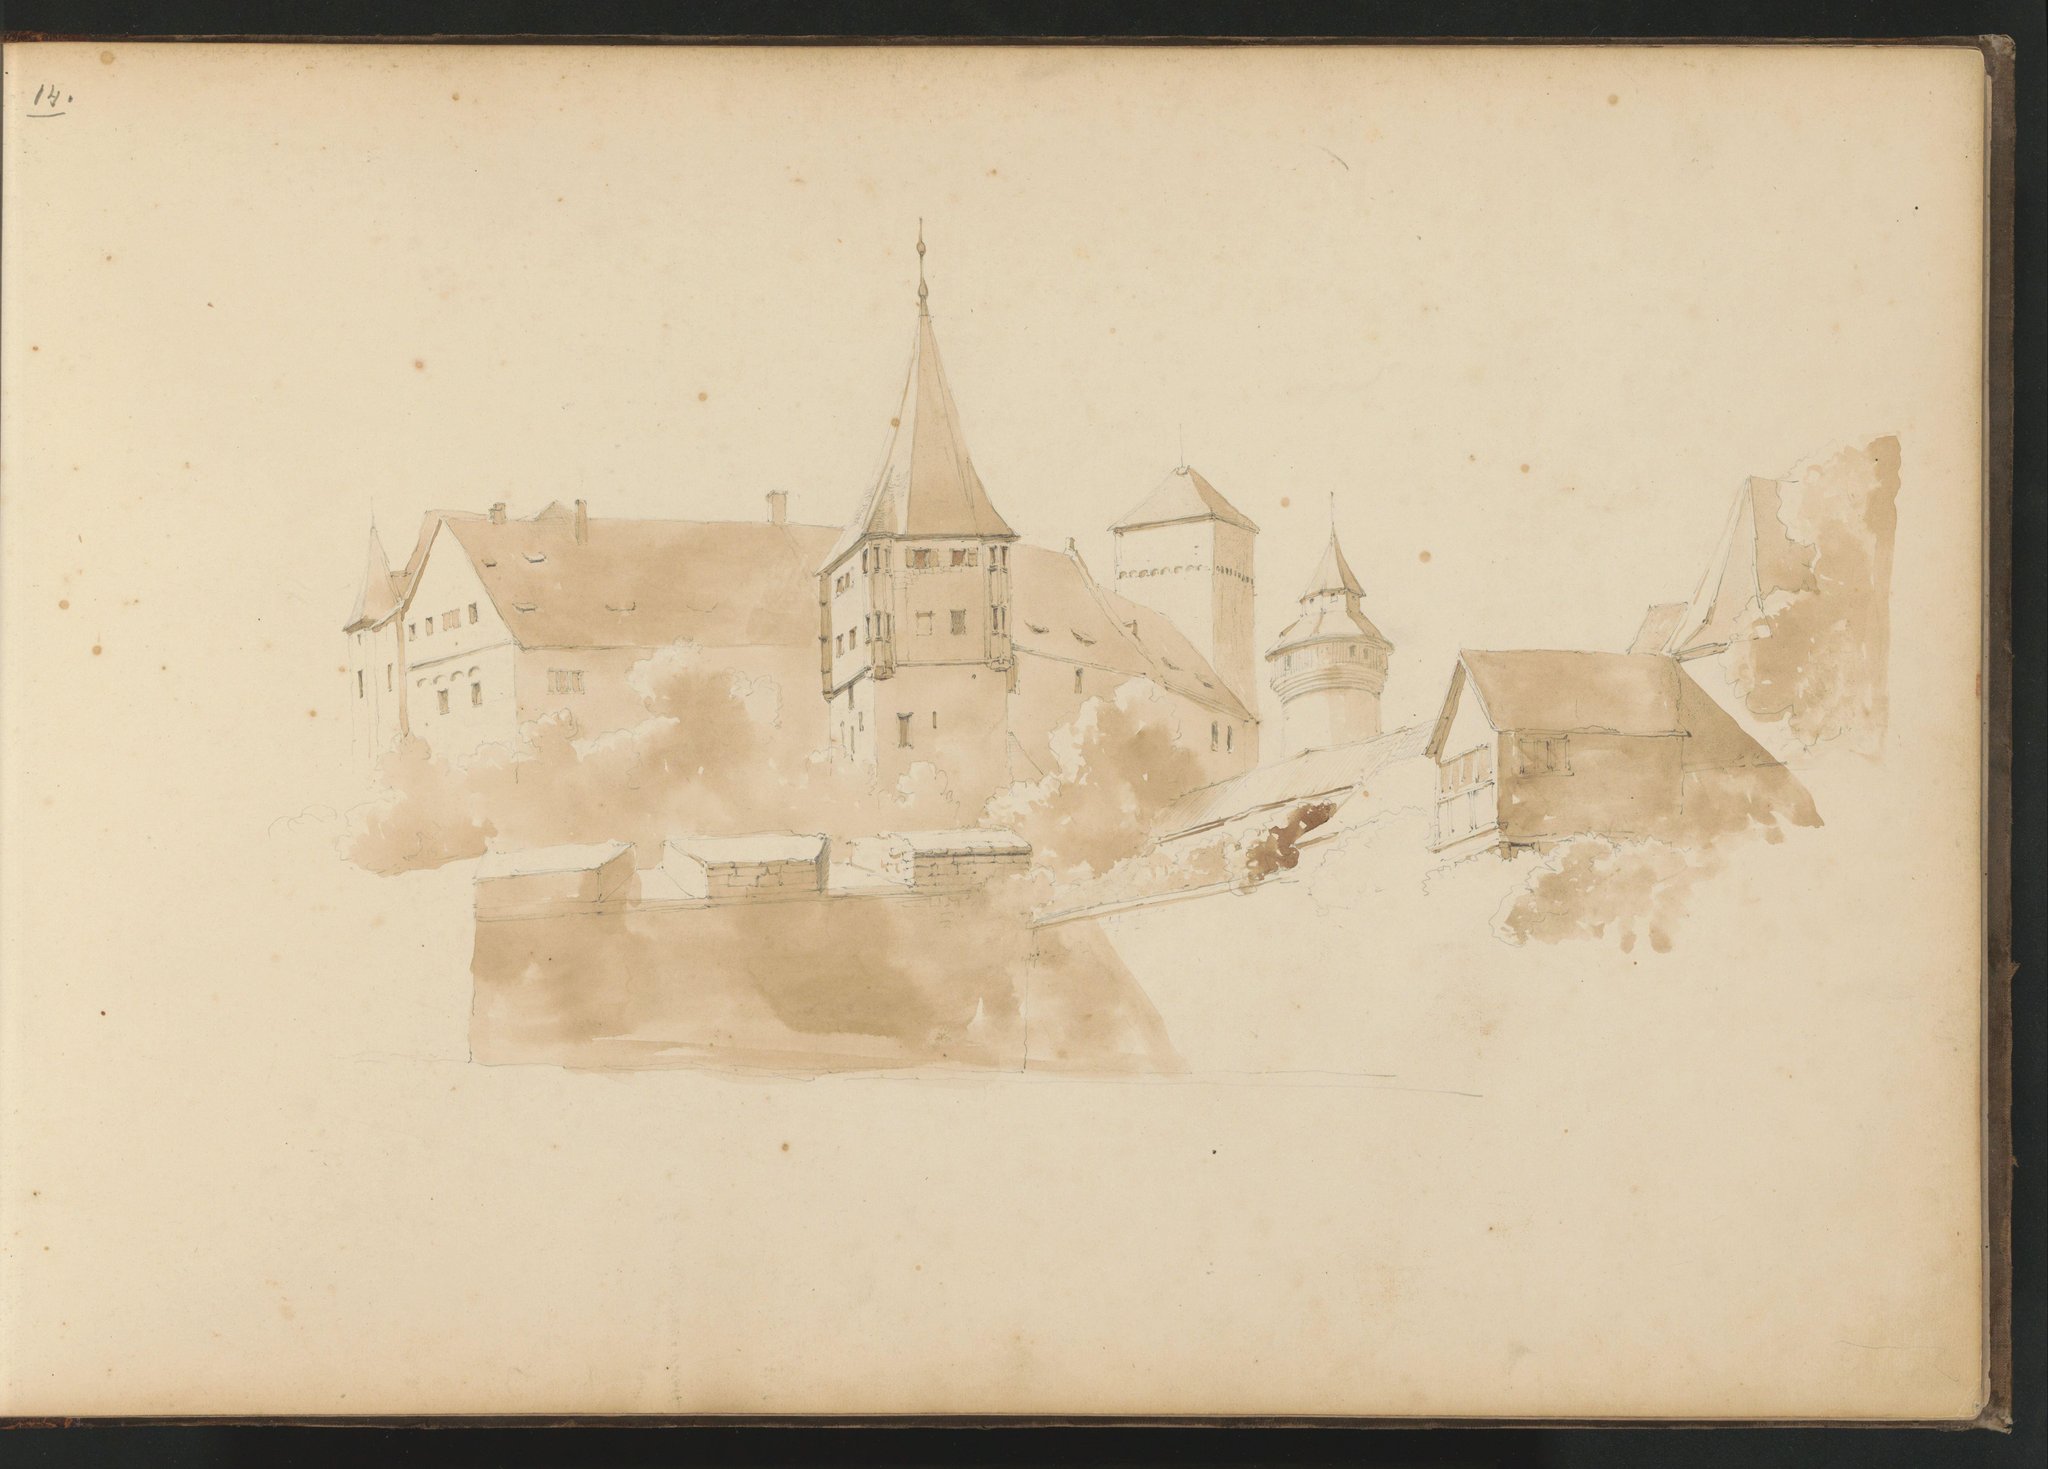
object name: sketchbook leaf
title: Stadsgezicht met vier torens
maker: kasparus karsen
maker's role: draughtsman, painter, print maker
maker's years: 1810-1896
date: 1820-1896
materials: paper, pencil, watercolor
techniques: brush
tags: tower (of house or building)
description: Blad 14 recto uit een schetsboek met 68 bladen.